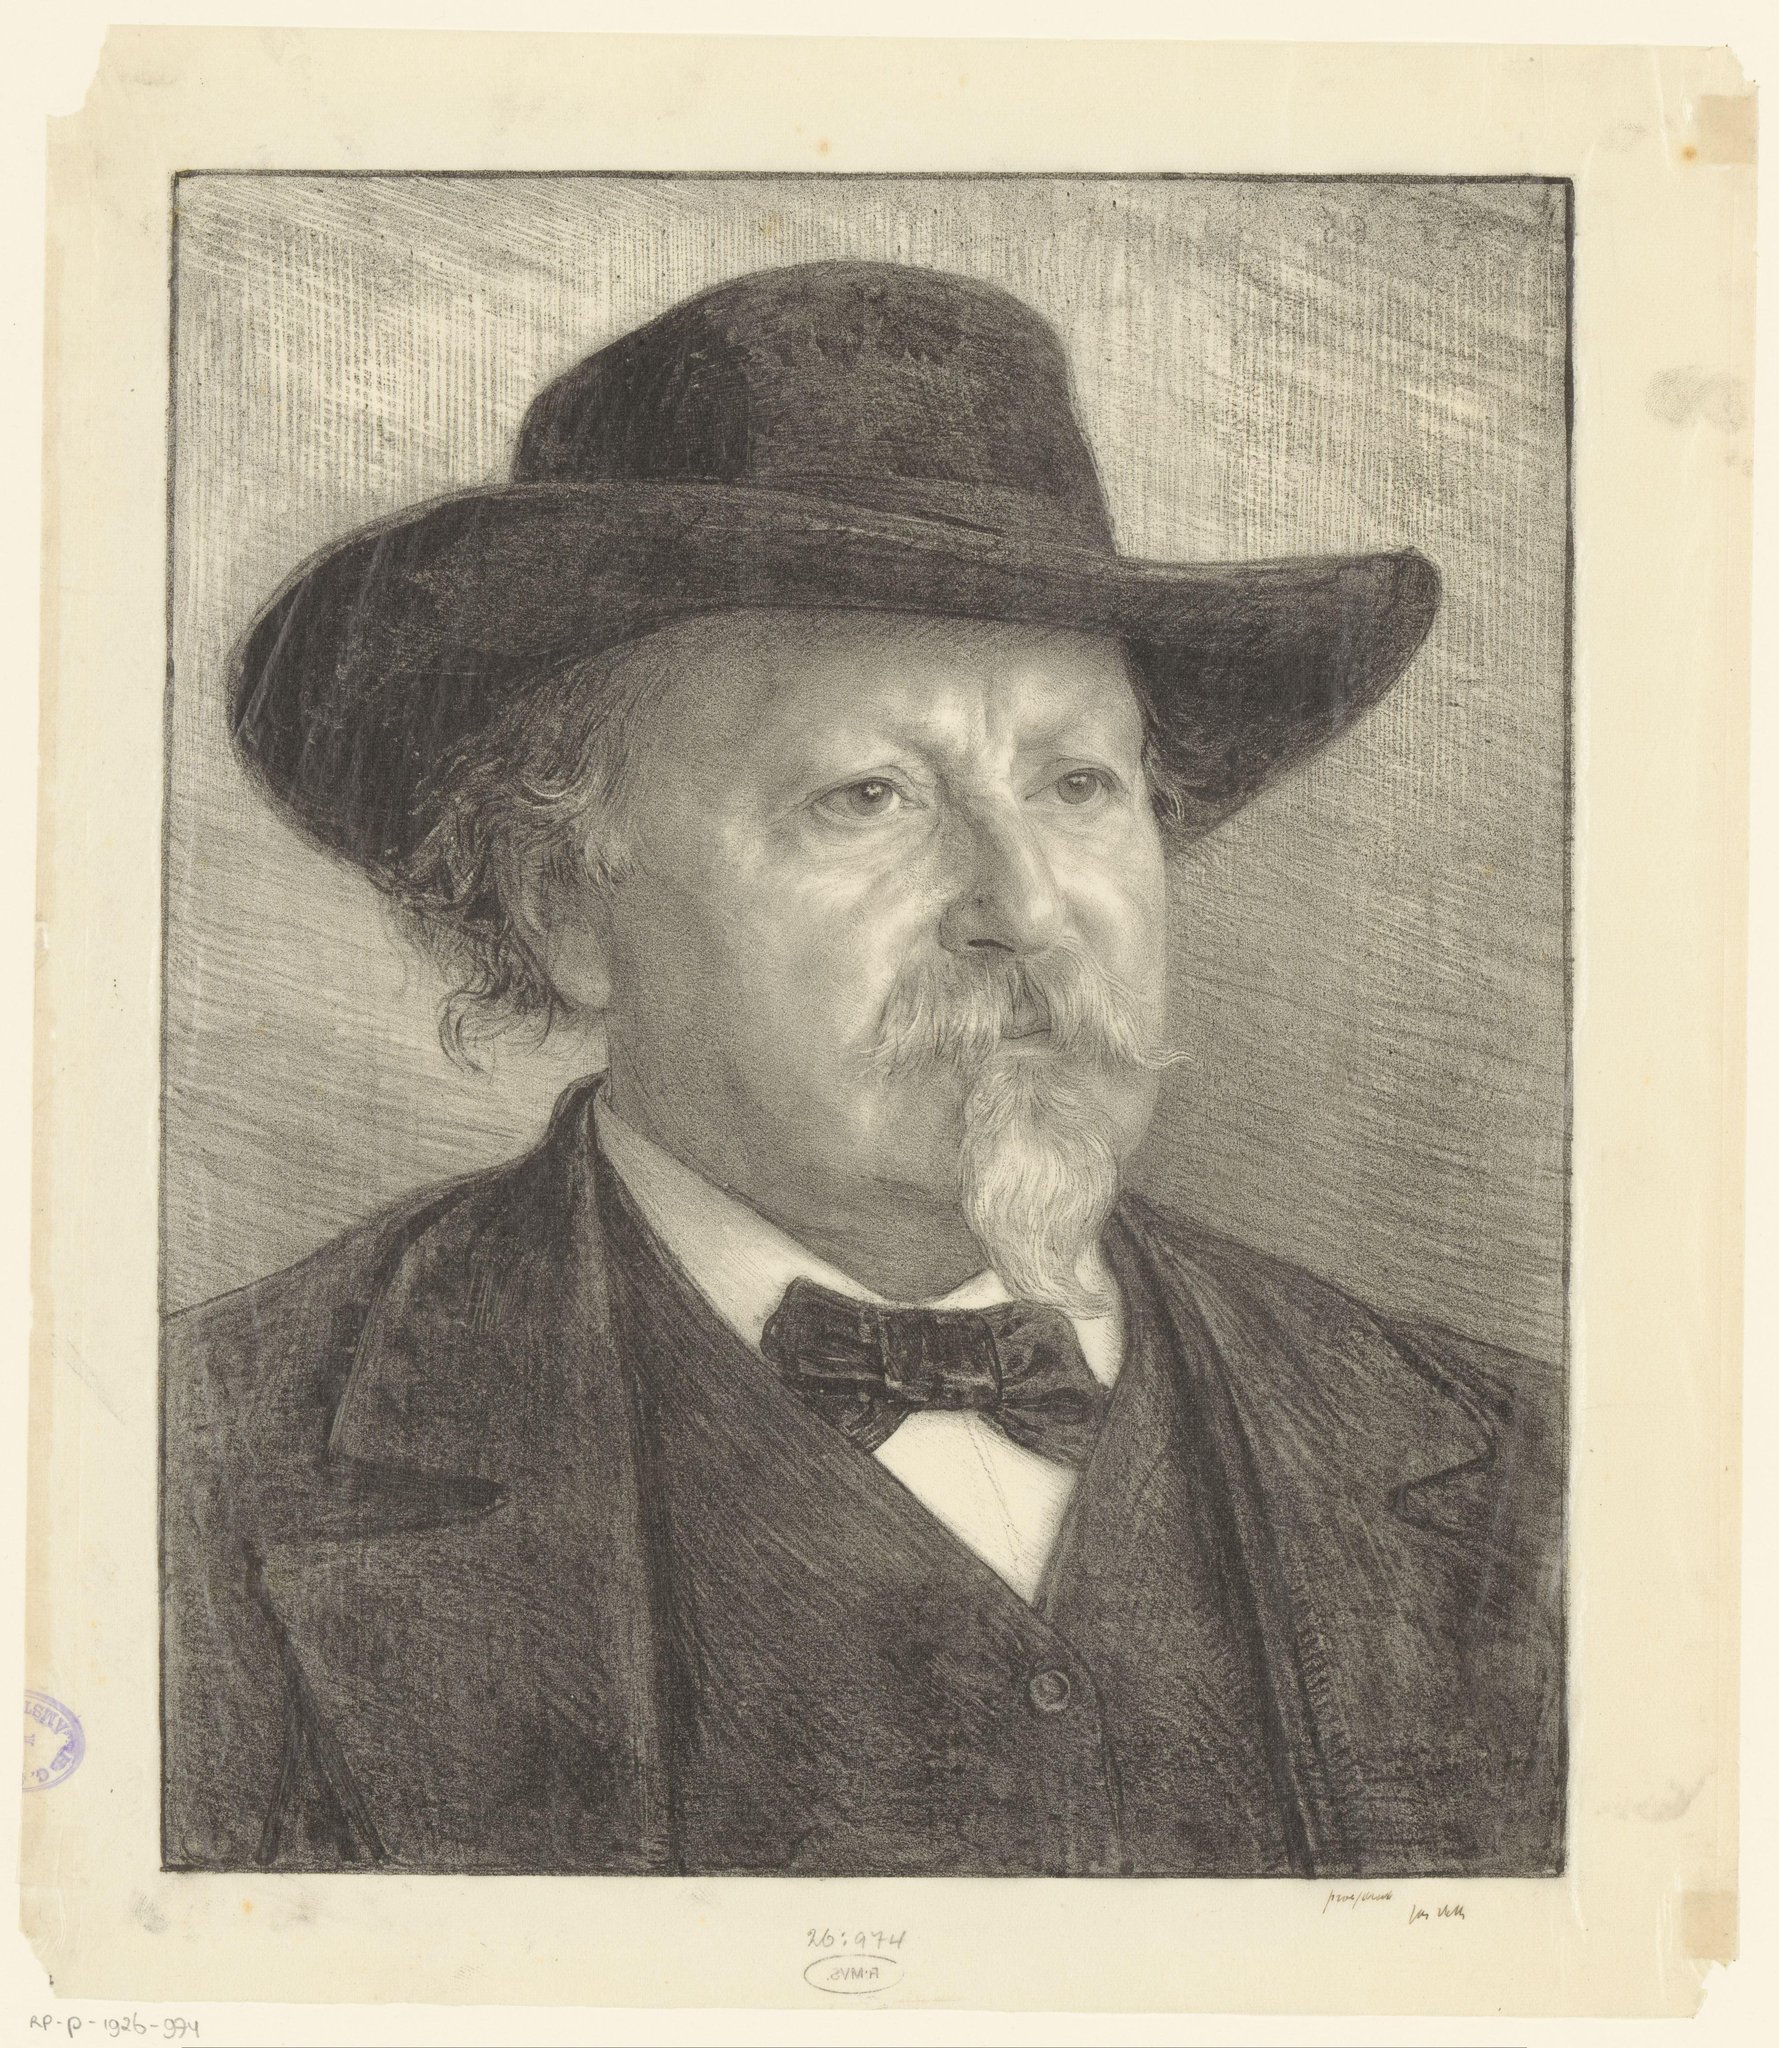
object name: print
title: Portret van Johan Philip van der Kellen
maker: jan veth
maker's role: designer, draughtsman, painter, print maker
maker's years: 1864-1925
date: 1897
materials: paper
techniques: lithograph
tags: utrecht, print maker, draughtsman, johan philip van der kellen, historical persons (+ (full) bust portrait)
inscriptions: inscription: ‘Proefdruk / Jan Veth’, collector's mark: Lugt 2228